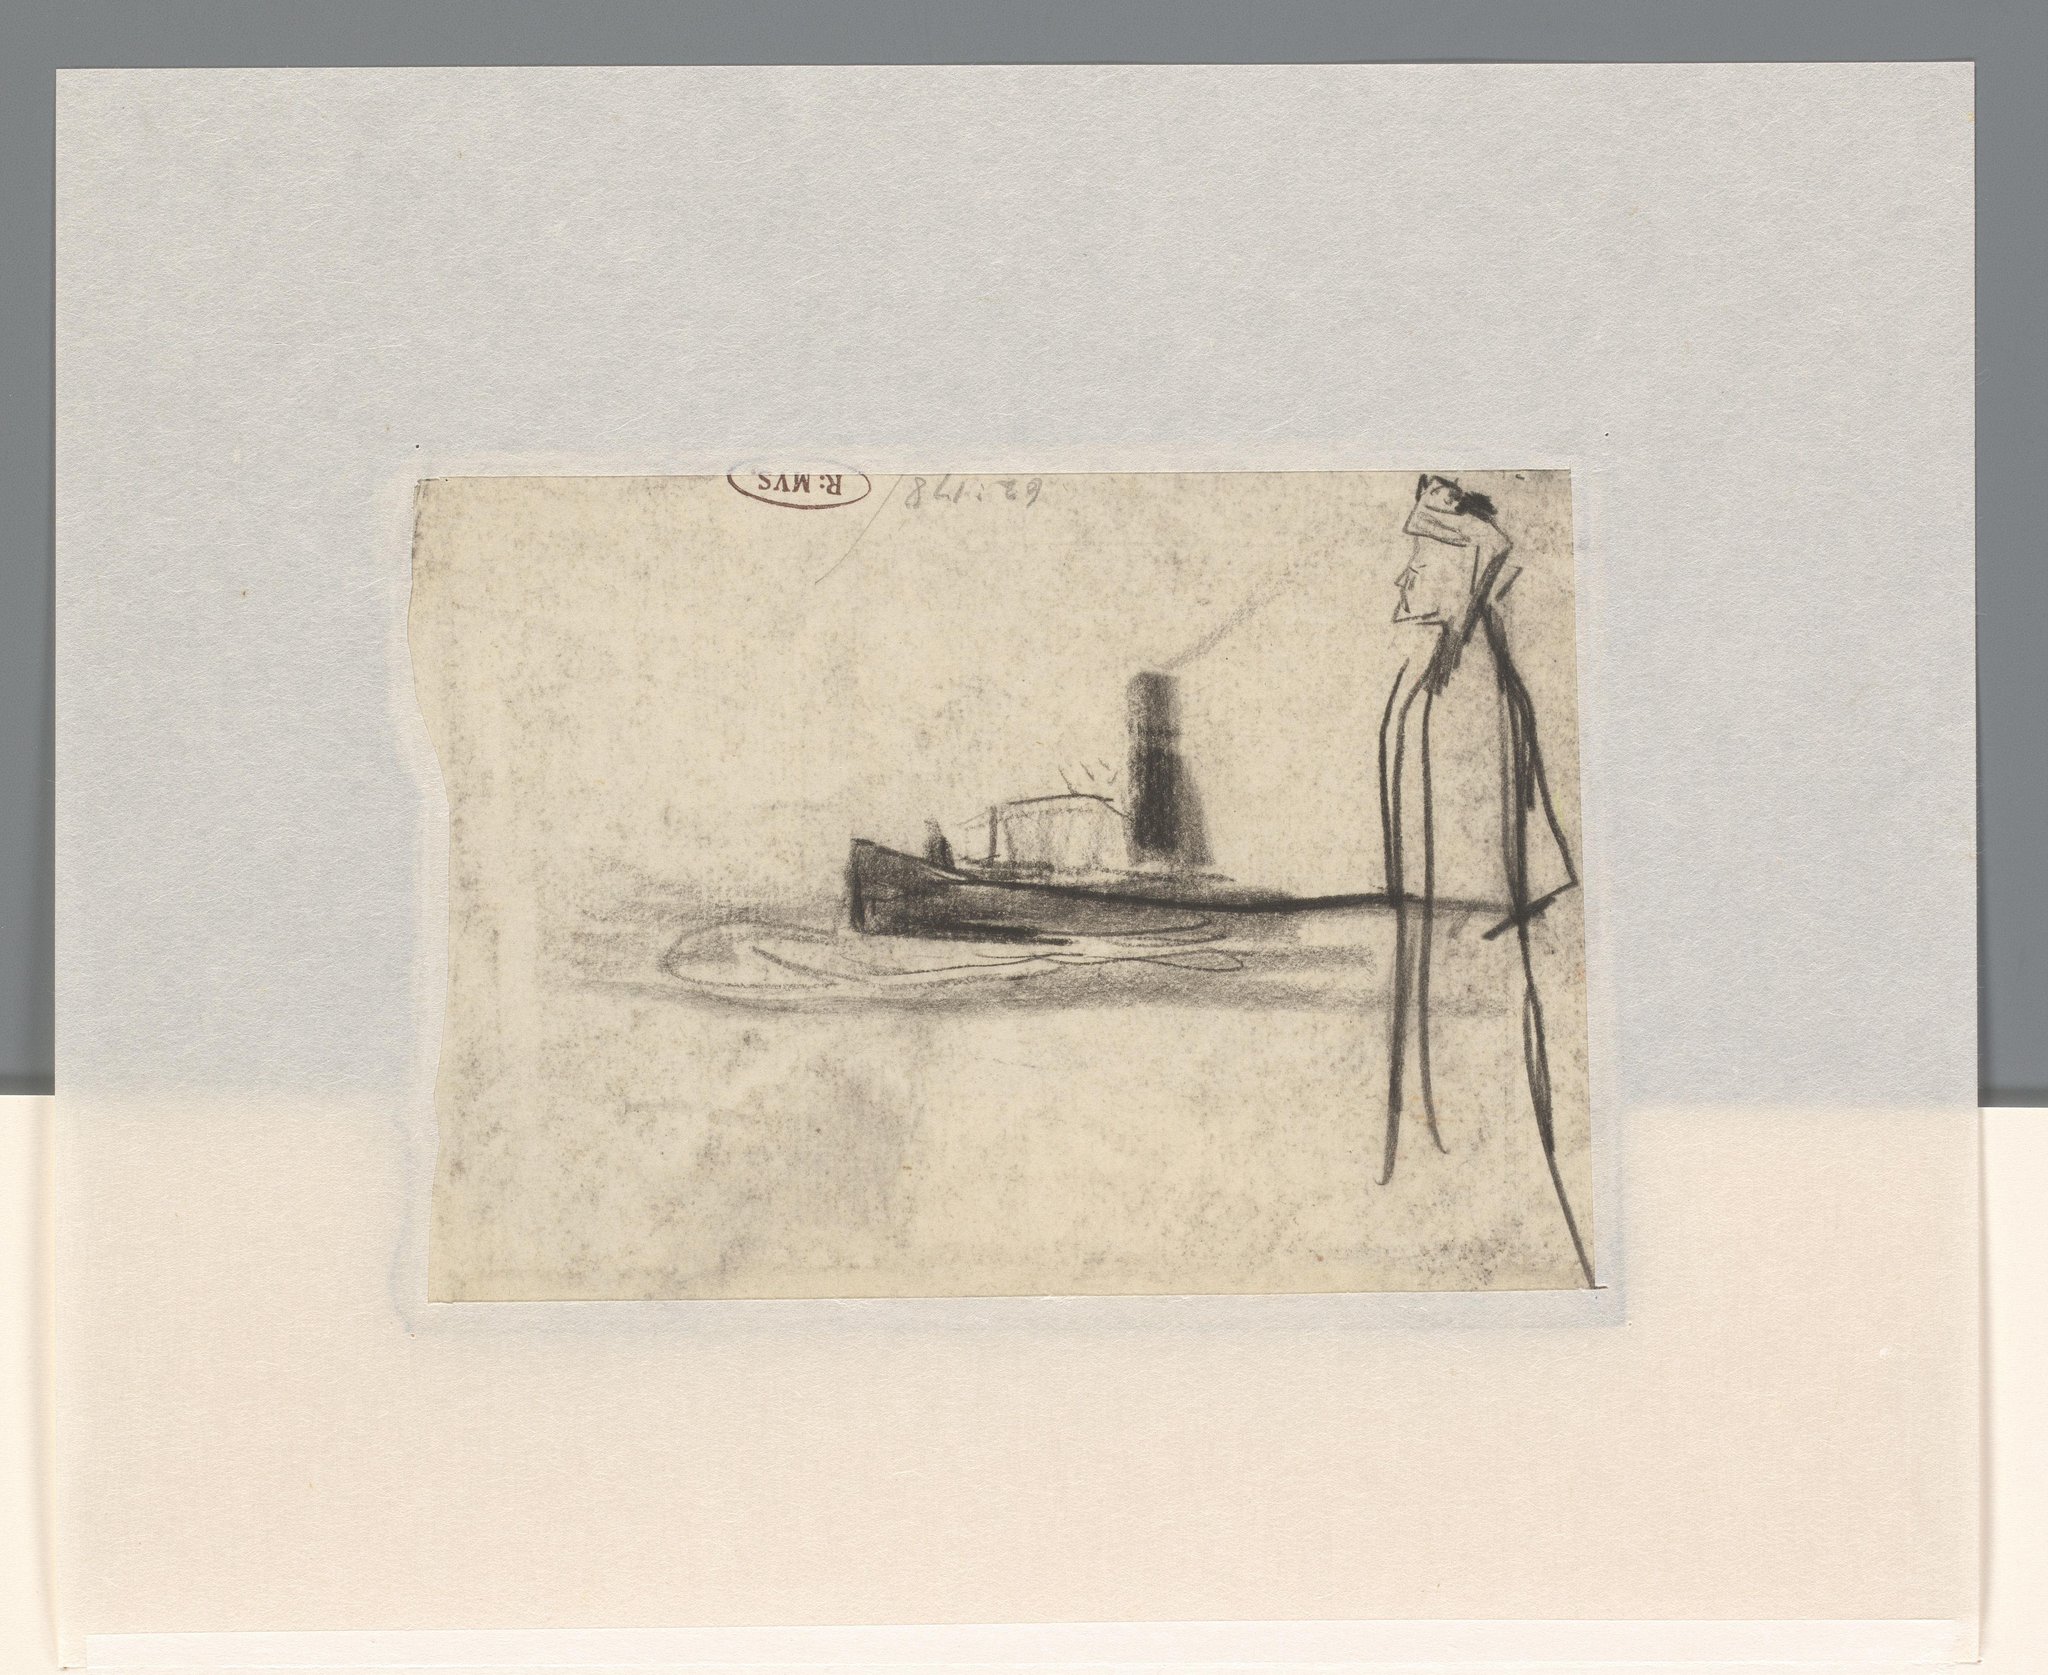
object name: drawing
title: Staande figuur en een sleepboot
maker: jan veth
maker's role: designer, draughtsman, painter, print maker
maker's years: 1864-1925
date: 1874-1925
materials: chalk, paper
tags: tug, pusher tug